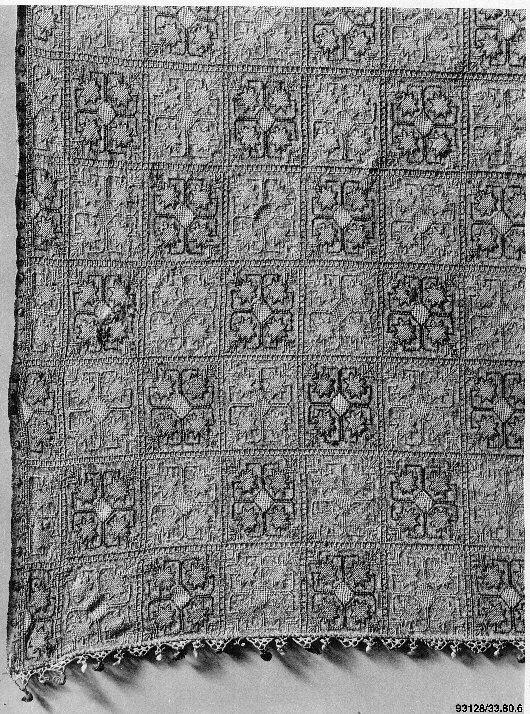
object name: cover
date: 1767-1800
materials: linen, silk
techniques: embroidery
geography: turkey